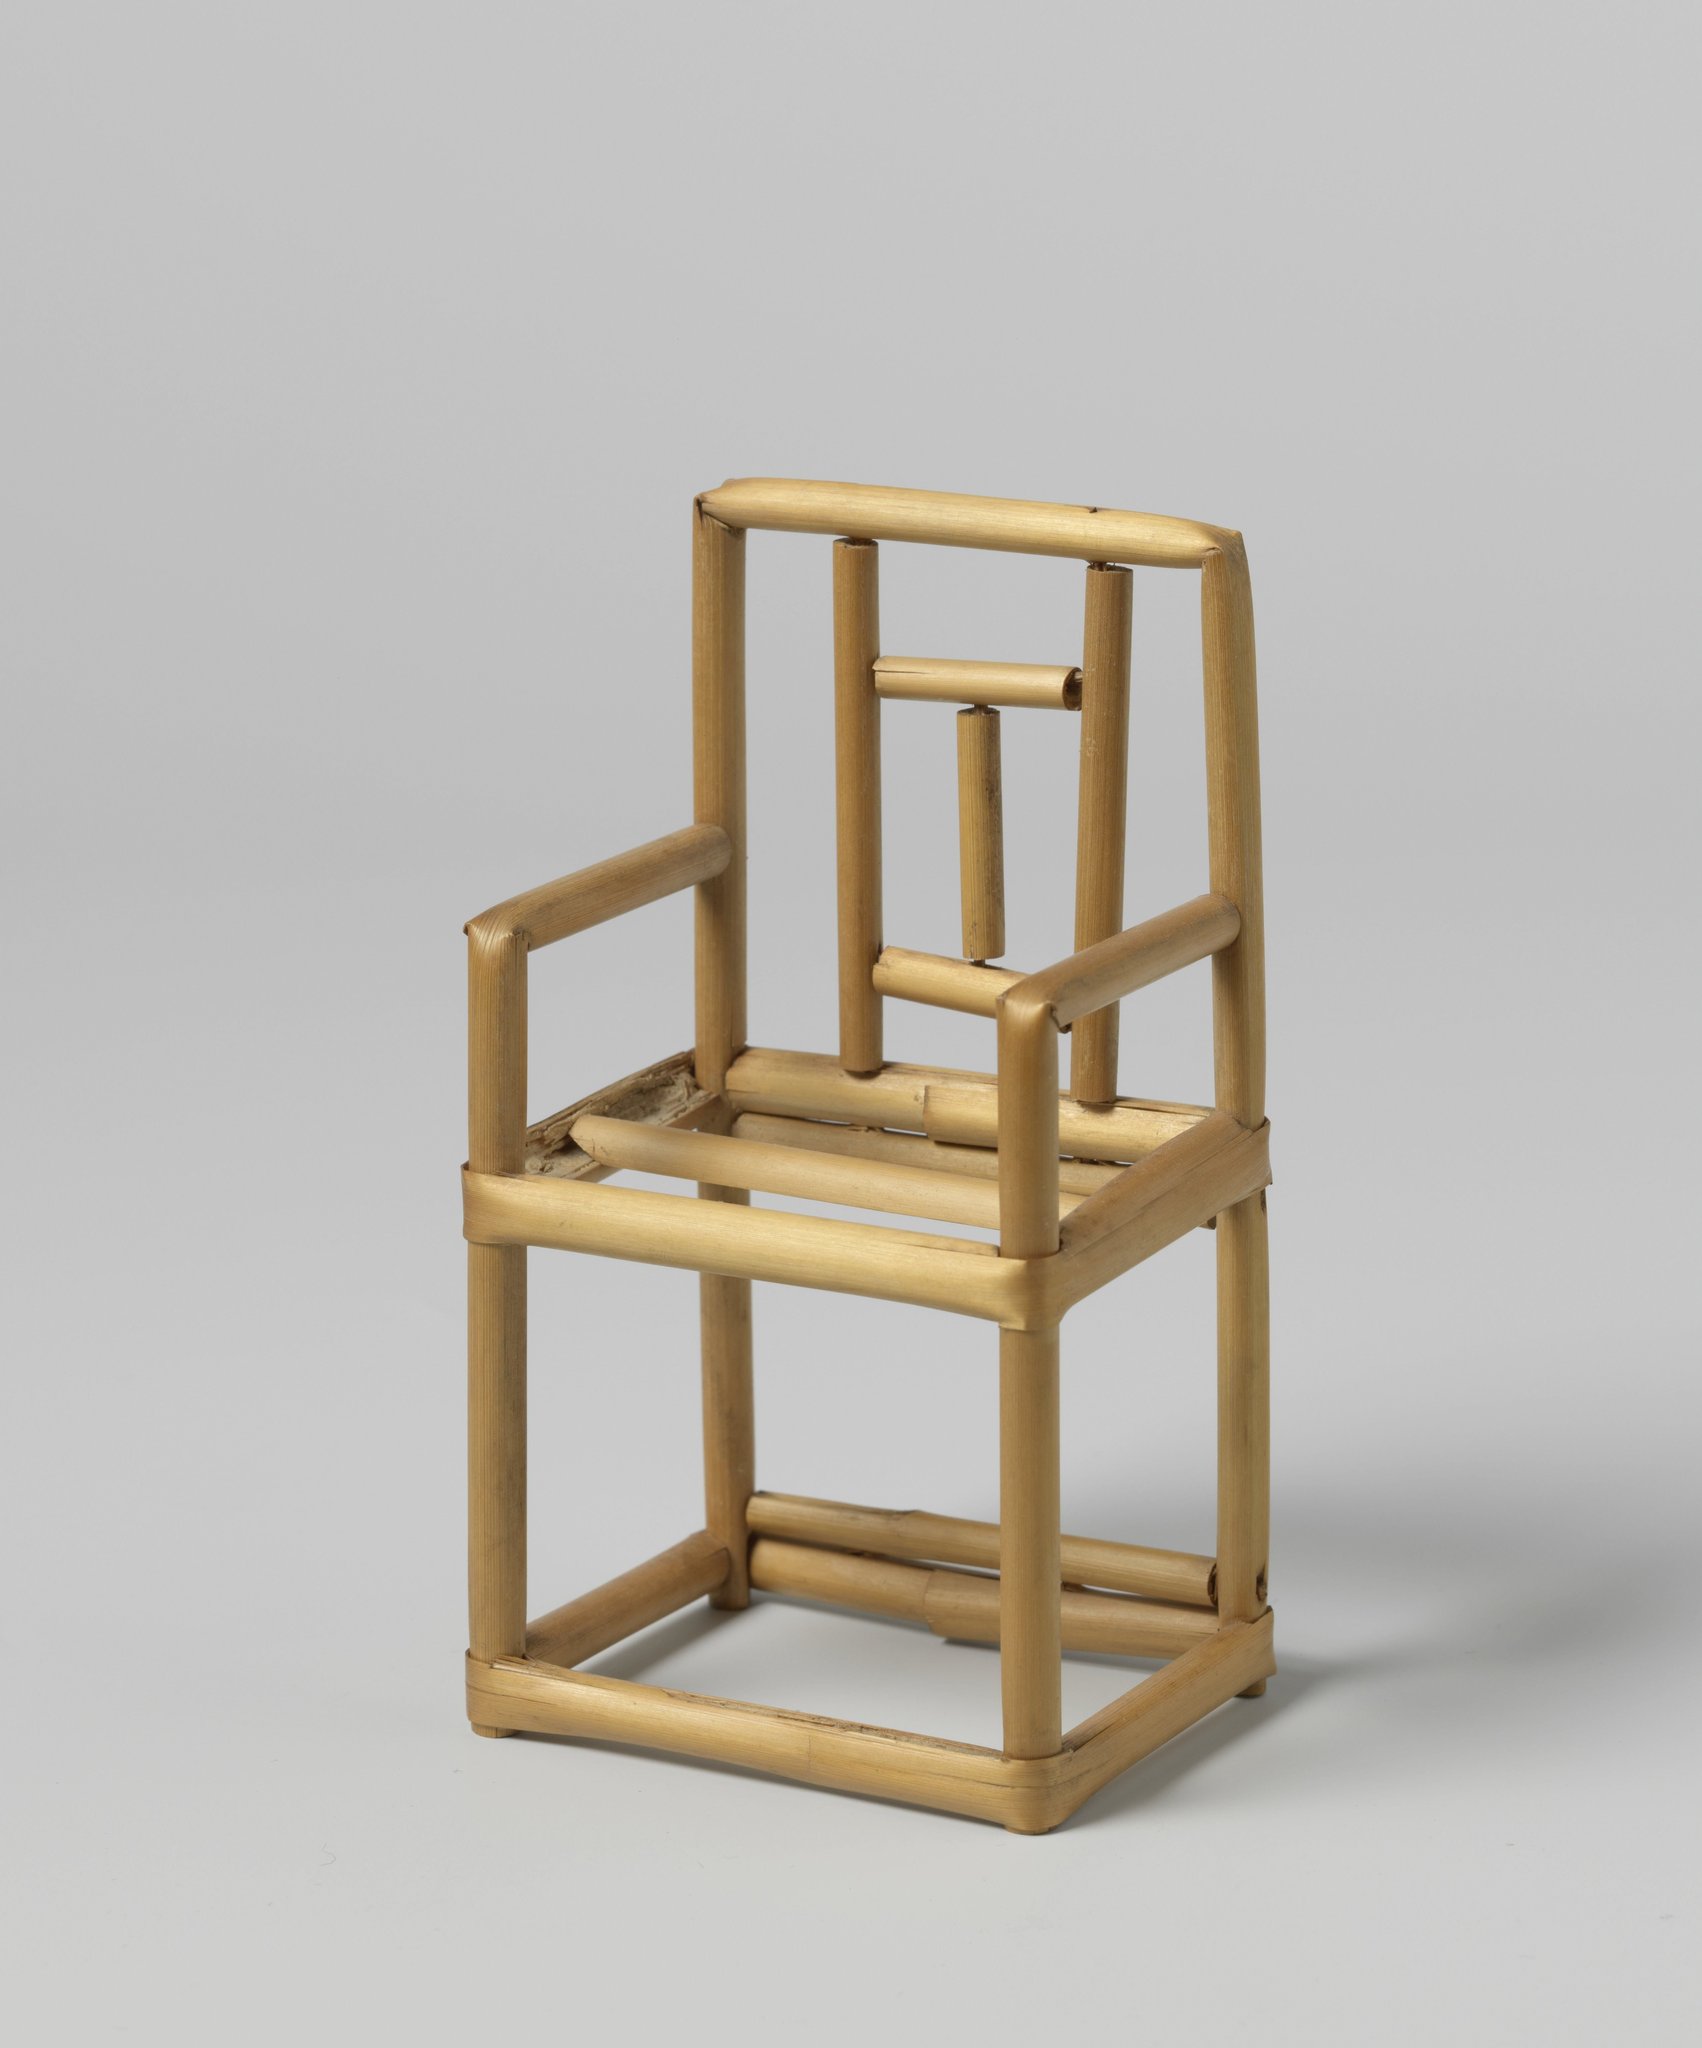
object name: miniature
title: Stoel van vlechtwerk, met geometrische motieven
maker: Anonymous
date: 1800-1899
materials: wood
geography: england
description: Stoel vervaardigd van gebogen, en op houten pennetjes geregen staafjes Kleine lisdodde. De rugleuning met geometrische motieven. De poten onderling verbonden met dwarsregels. De zitting is vervaardigd van 5 in de breedte bevestigde gehalveerde stengels.